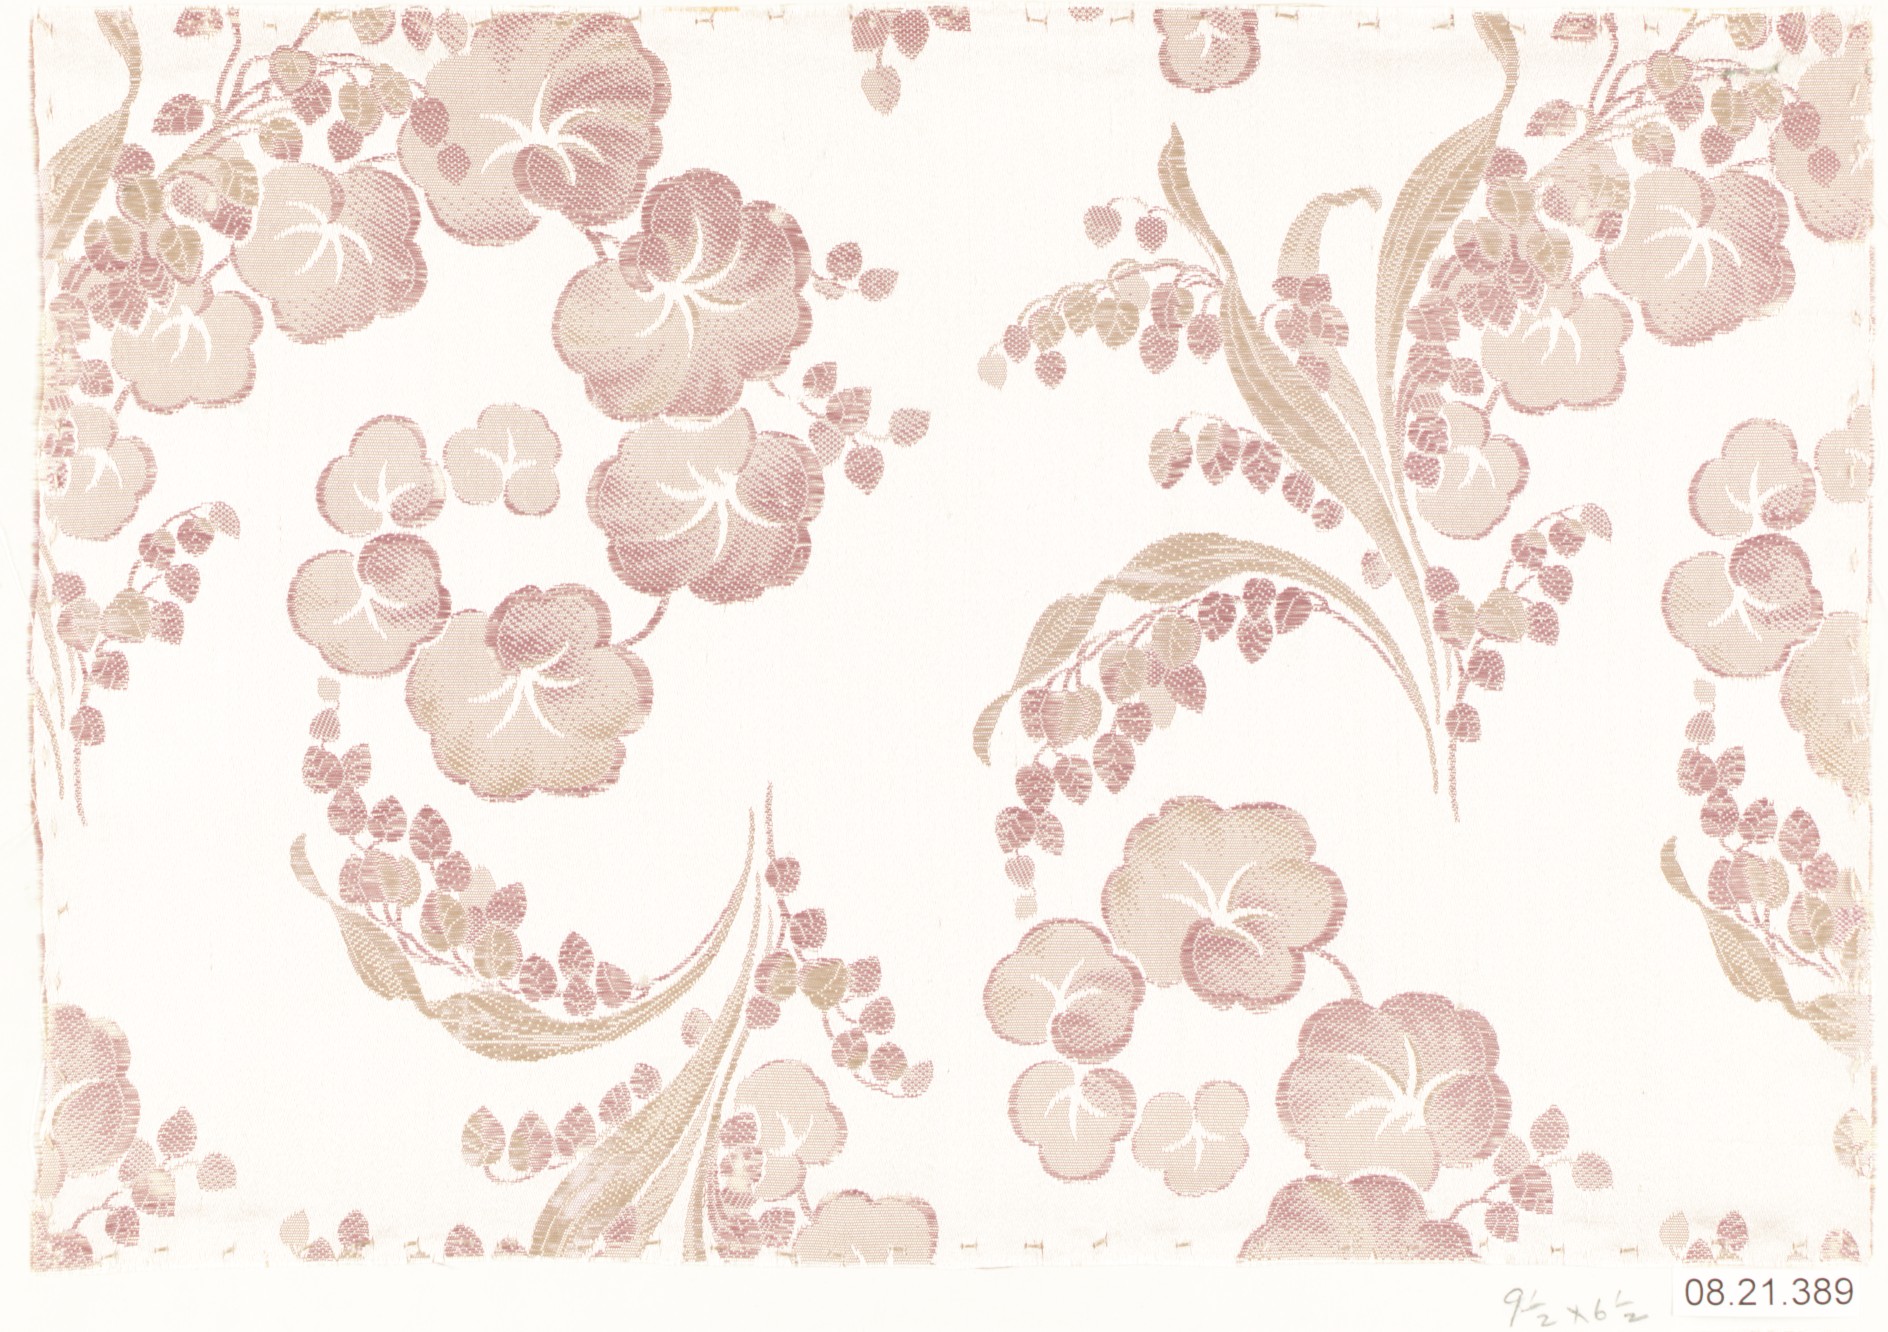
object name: textile sample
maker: Anonymous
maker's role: designer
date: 1900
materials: silk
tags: flowers,leaves